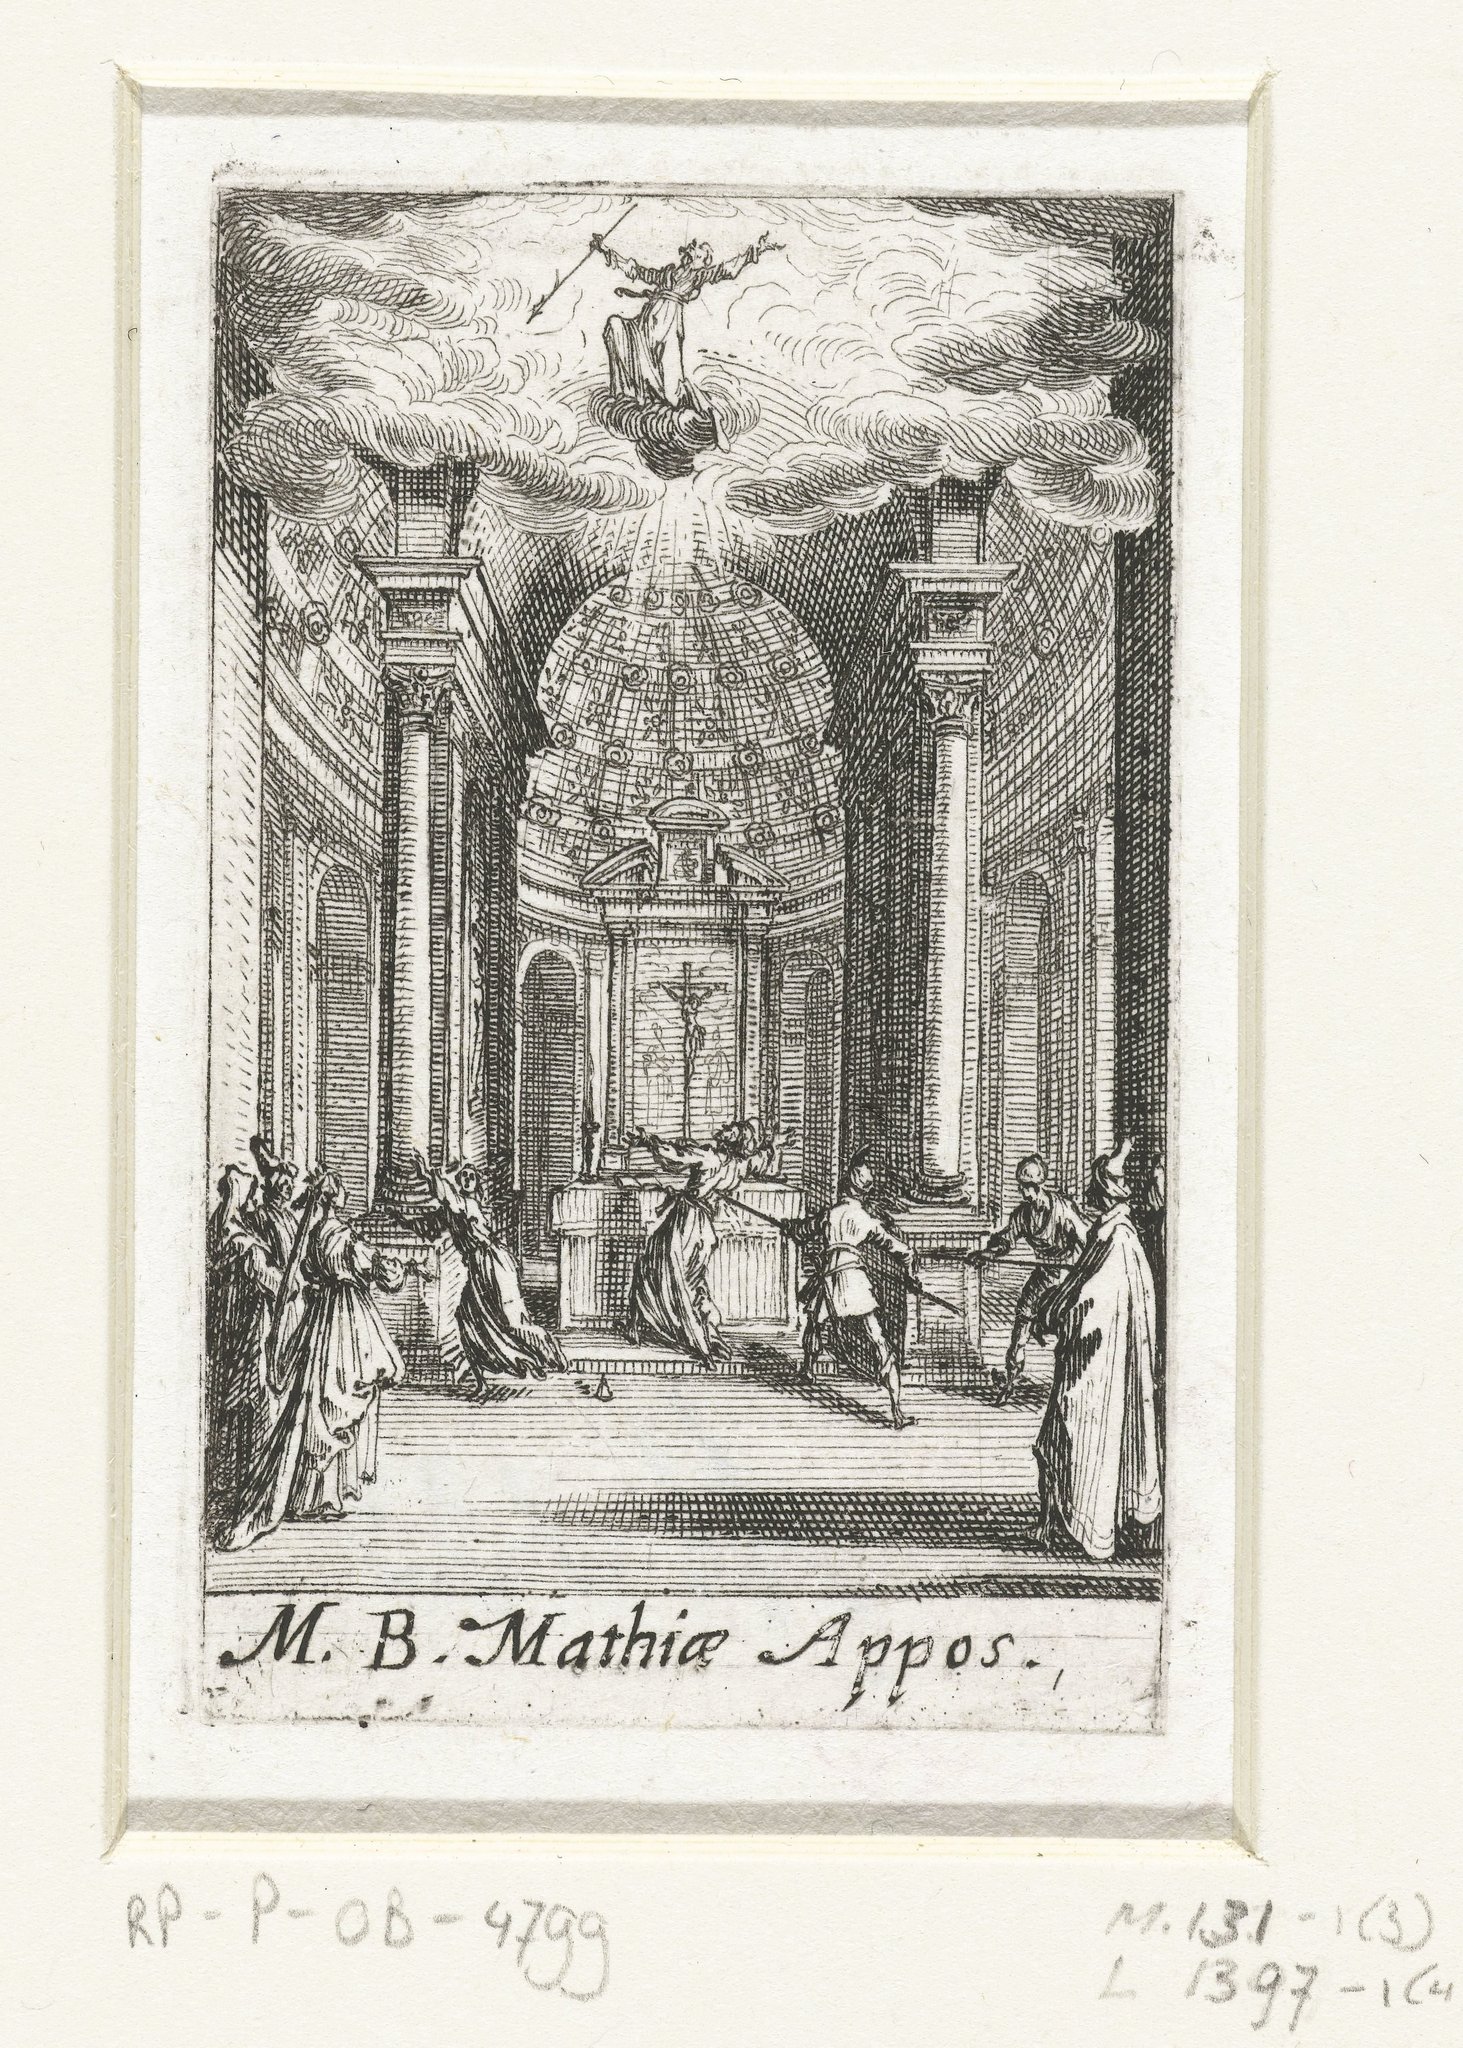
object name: print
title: M. B. Mathiae Appos.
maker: jacques callot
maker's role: draughtsman, print maker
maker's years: 1592-1635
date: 1632-1634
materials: paper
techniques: etching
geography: nancy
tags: martyrdom and death of matthias, the apostle and martyr matthias; possible attributes: axe, book, cross, halberd, scroll, sword - martyrdom, suffering, misfortune, death of male saint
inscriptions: collector's mark: Lugt 240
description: Matthias wordt voor een altaar doodgestoken door een man met een speer. Boven deze scène is Matthias nogmaals afgebeeld, op een wolk in de hemel, een speer in de hand. Onder de voorstelling een onderschrift in Latijn. Deze prent is onderdeel van een reeks van 16 prenten, bestaande uit een titelblad en 15 voorstellingen van de martelingen die de apostelen hebben ondergaan. NB: deze marteldood is eerder typerend voor Mattheüs dan voor Matthias; hier is echter de naam van Matthias aangehouden, omdat die ook in het onderschrift staat.